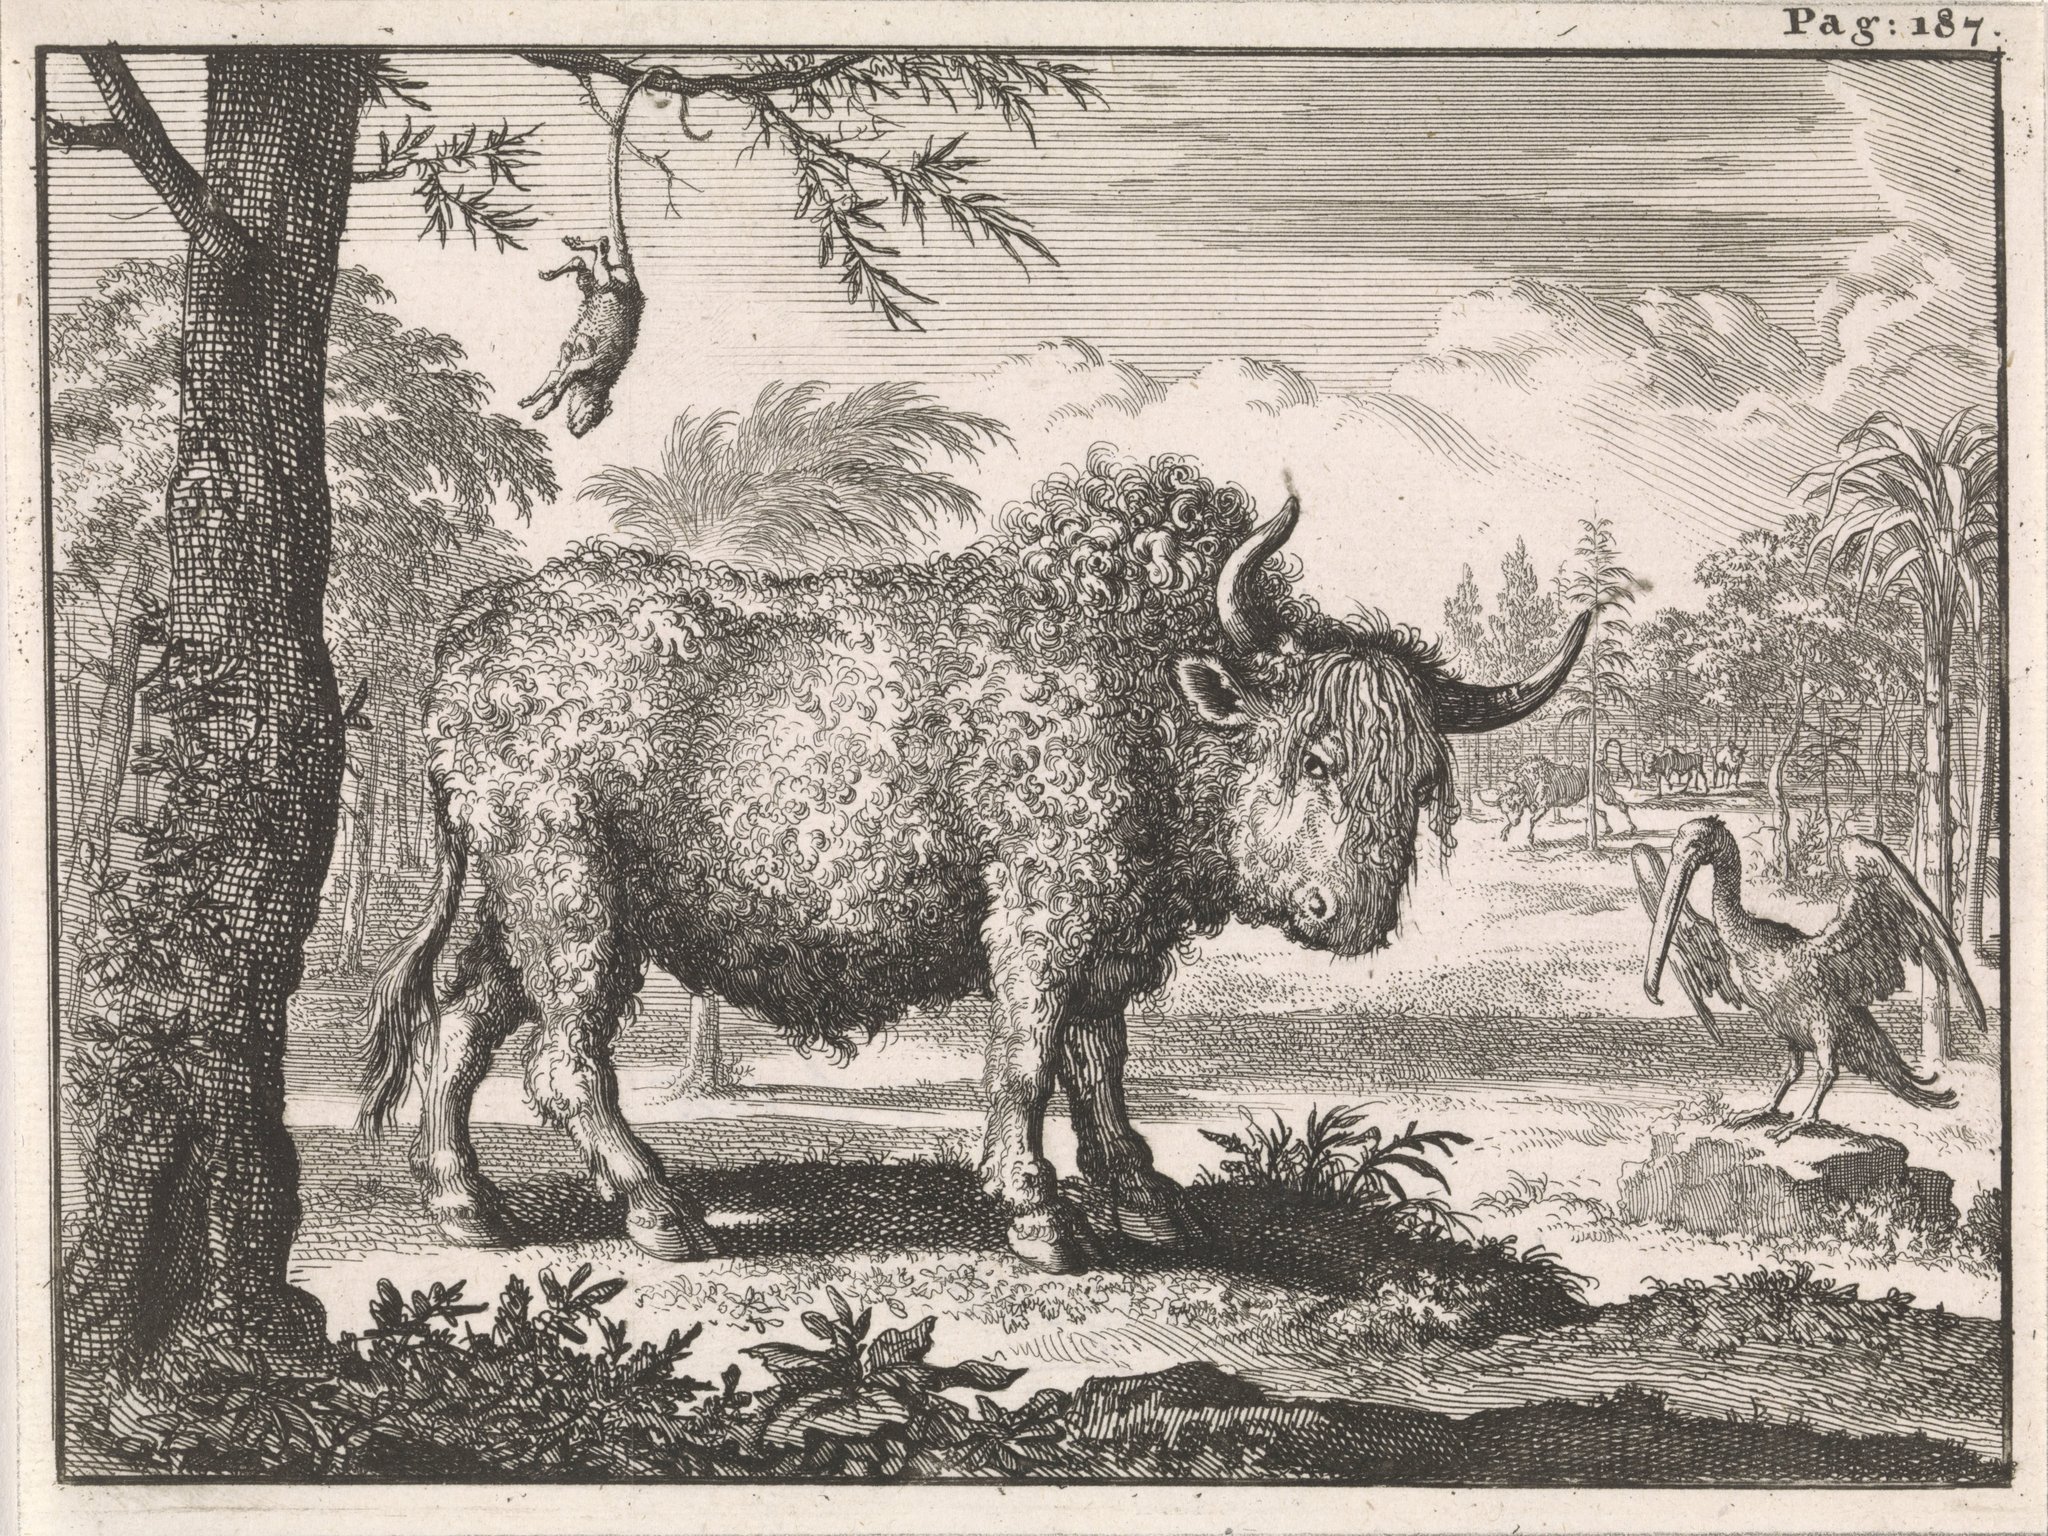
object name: book illustration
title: Bizon, opposum en een pelikaan in een exotisch landschap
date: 1697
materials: paper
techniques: etching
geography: amsterdam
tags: mammals, landscapes in the non-temperate zone, exotic landscapes, hoofed animals: bison, water-birds: pelican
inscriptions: collector's mark: Lugt 2228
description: Illustratie uit: Hennepin, Louis. Nouvelle decouverte d'un tres grand pays situé dans l'Amerique, entre le Nouveau Mexique, et la mer Glaciale. Utrecht: Willem Broedelet, 1697.